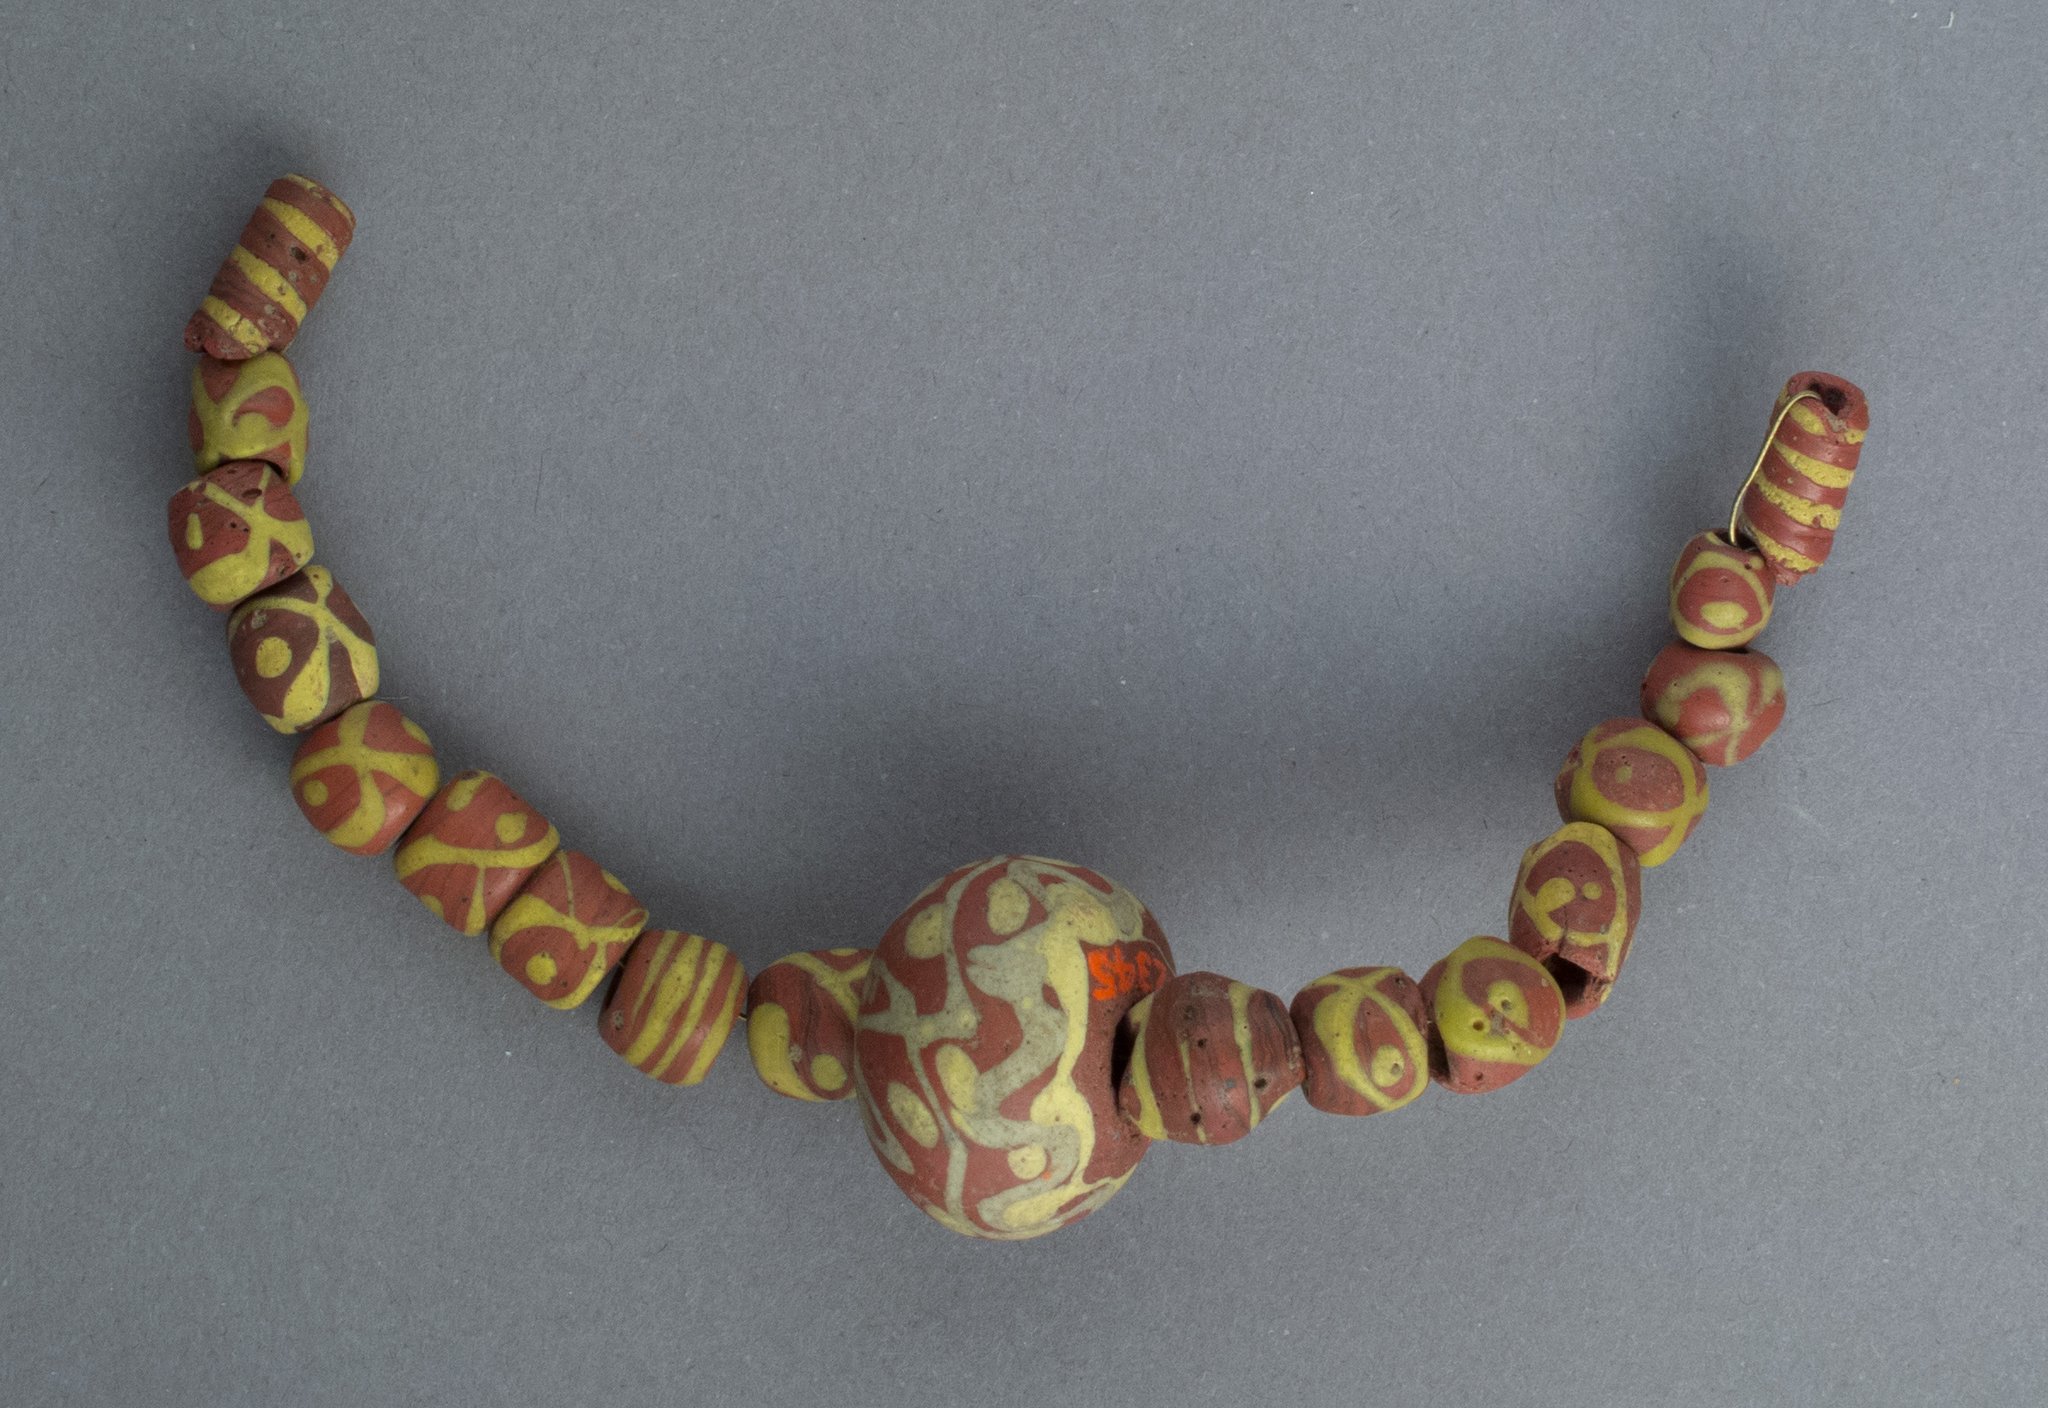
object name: bead, 18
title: Beads, 18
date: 7000 BCE-330 CE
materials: glass